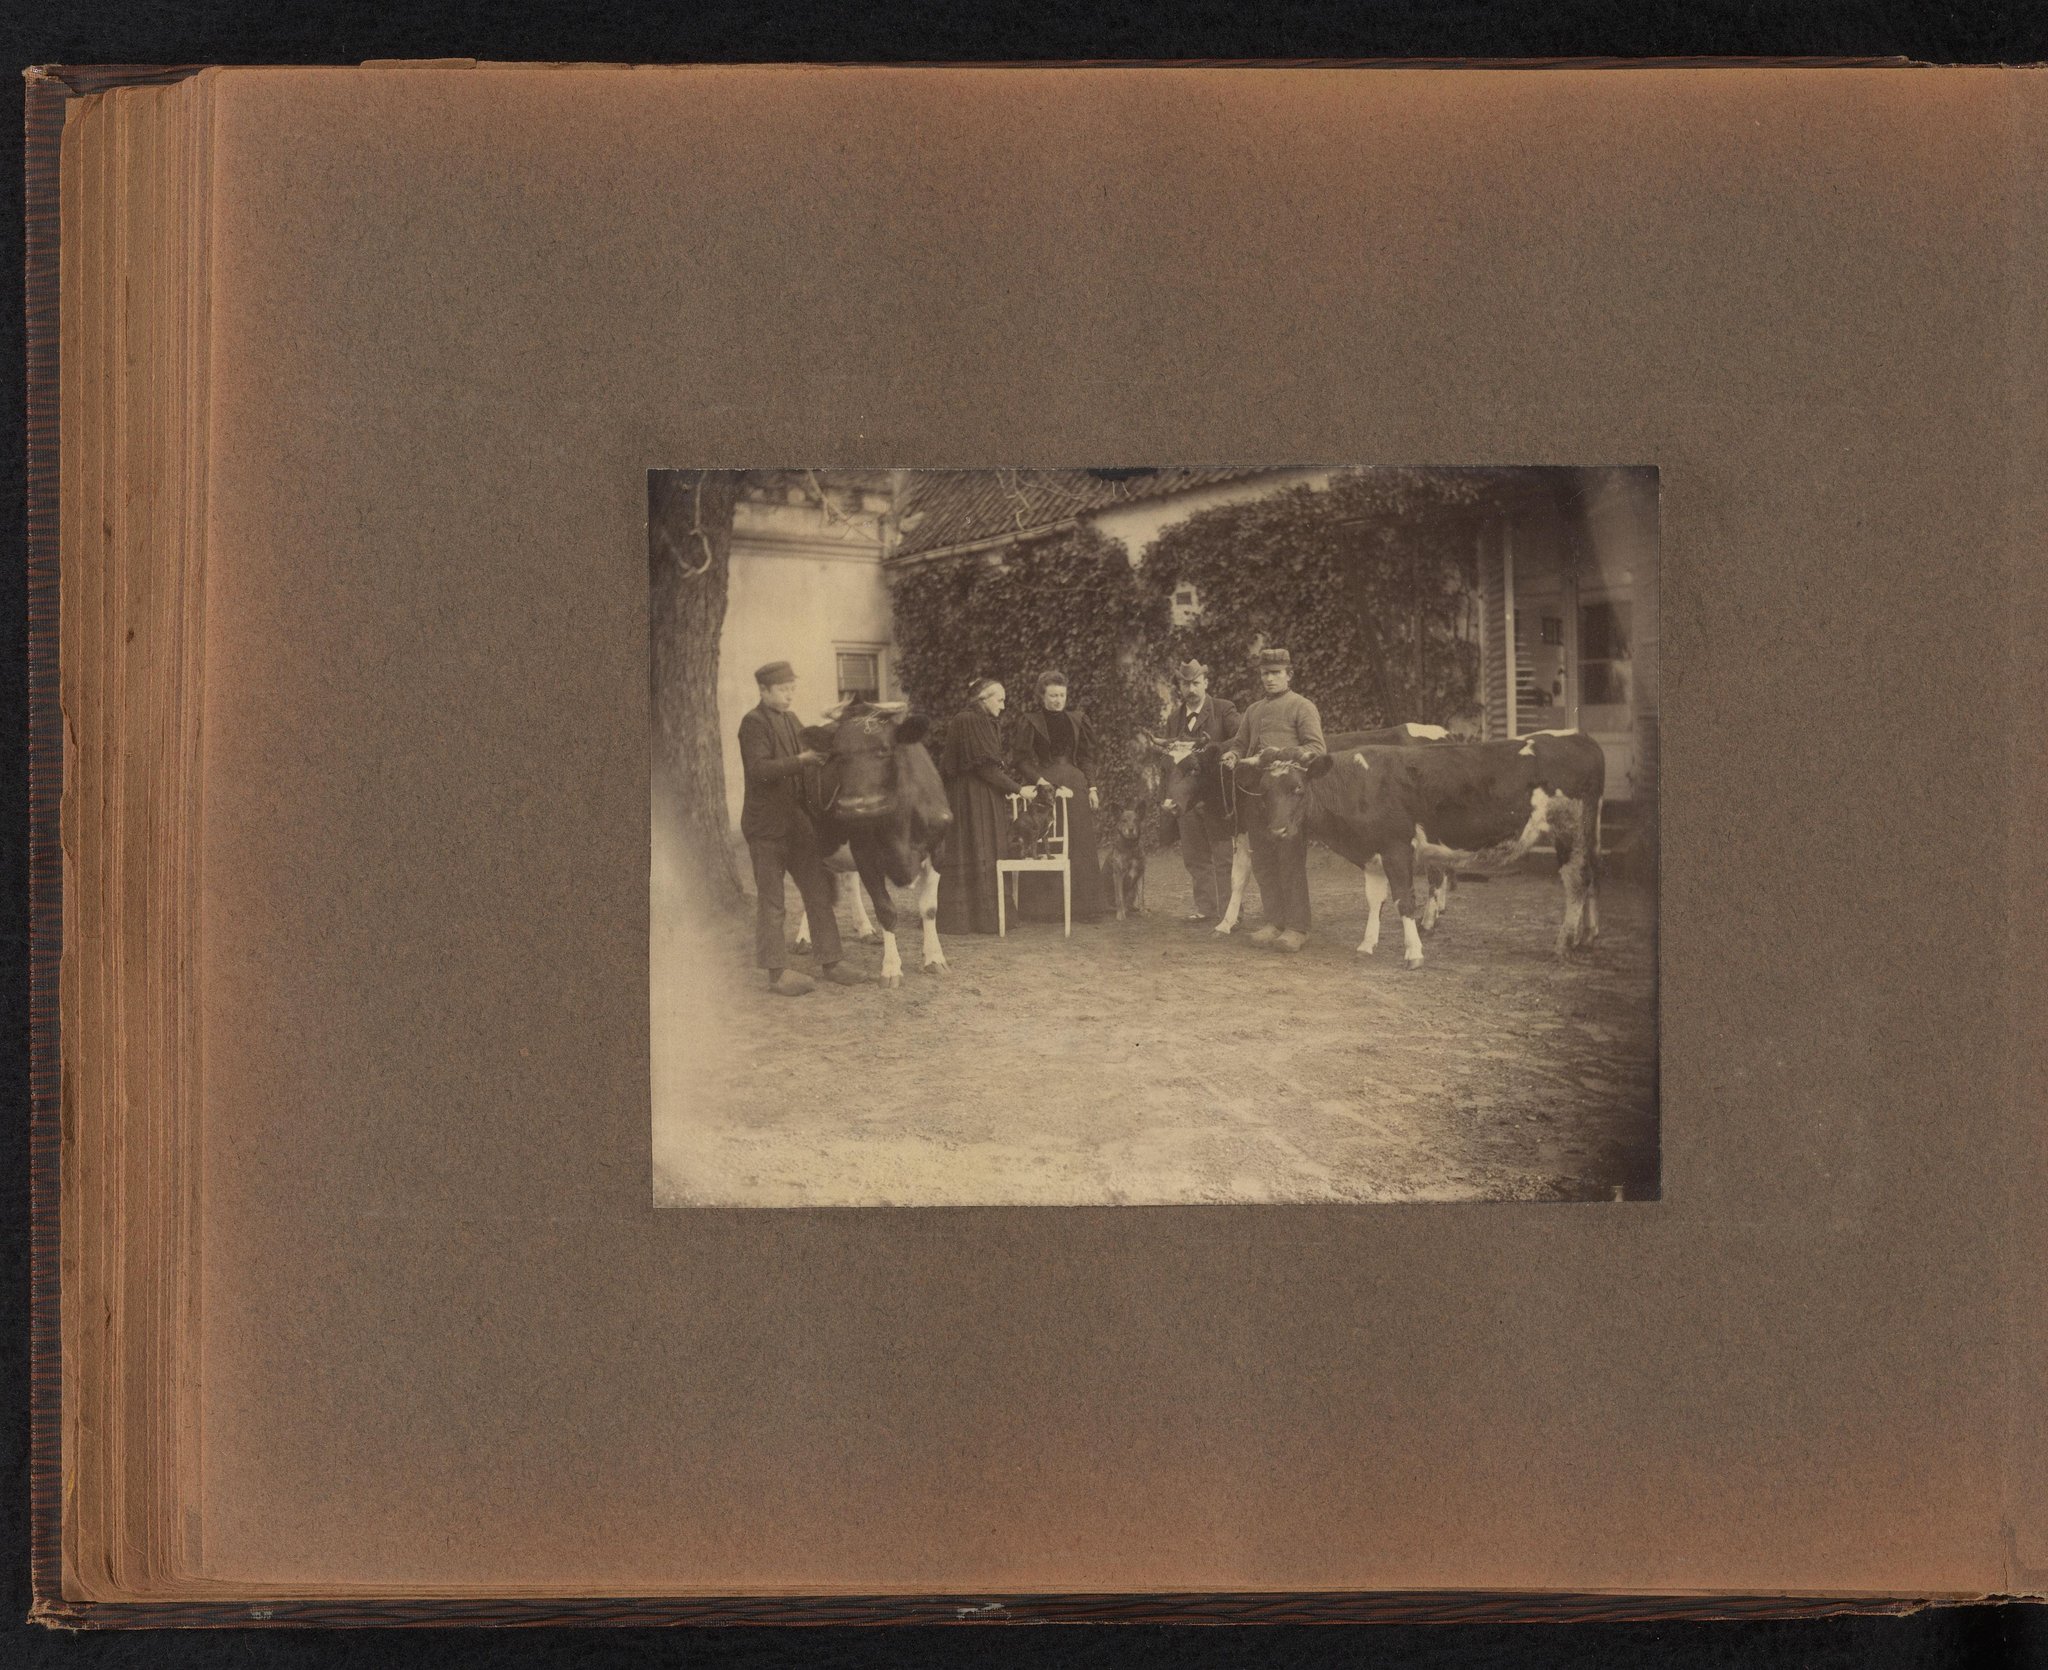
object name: photograph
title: Bladzijde uit het fotoalbum van de familie Diepenbrock met 1 foto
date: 1870-1920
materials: cardboard, photographic support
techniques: photography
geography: amsterdam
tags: netherlands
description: Bruin albumblad 38 van familiealbum van Alphons Diepenbrock.